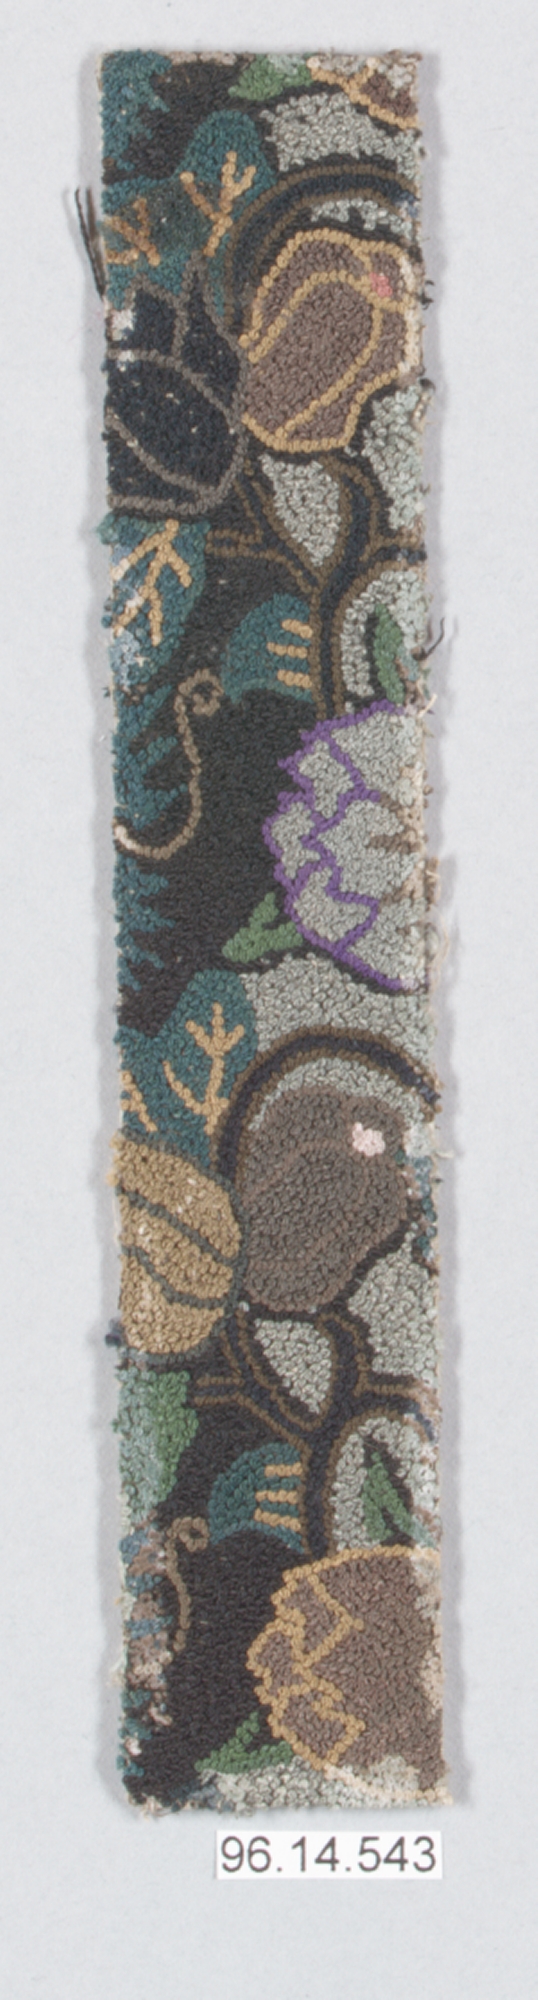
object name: piece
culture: japanese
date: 1701-1900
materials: silk